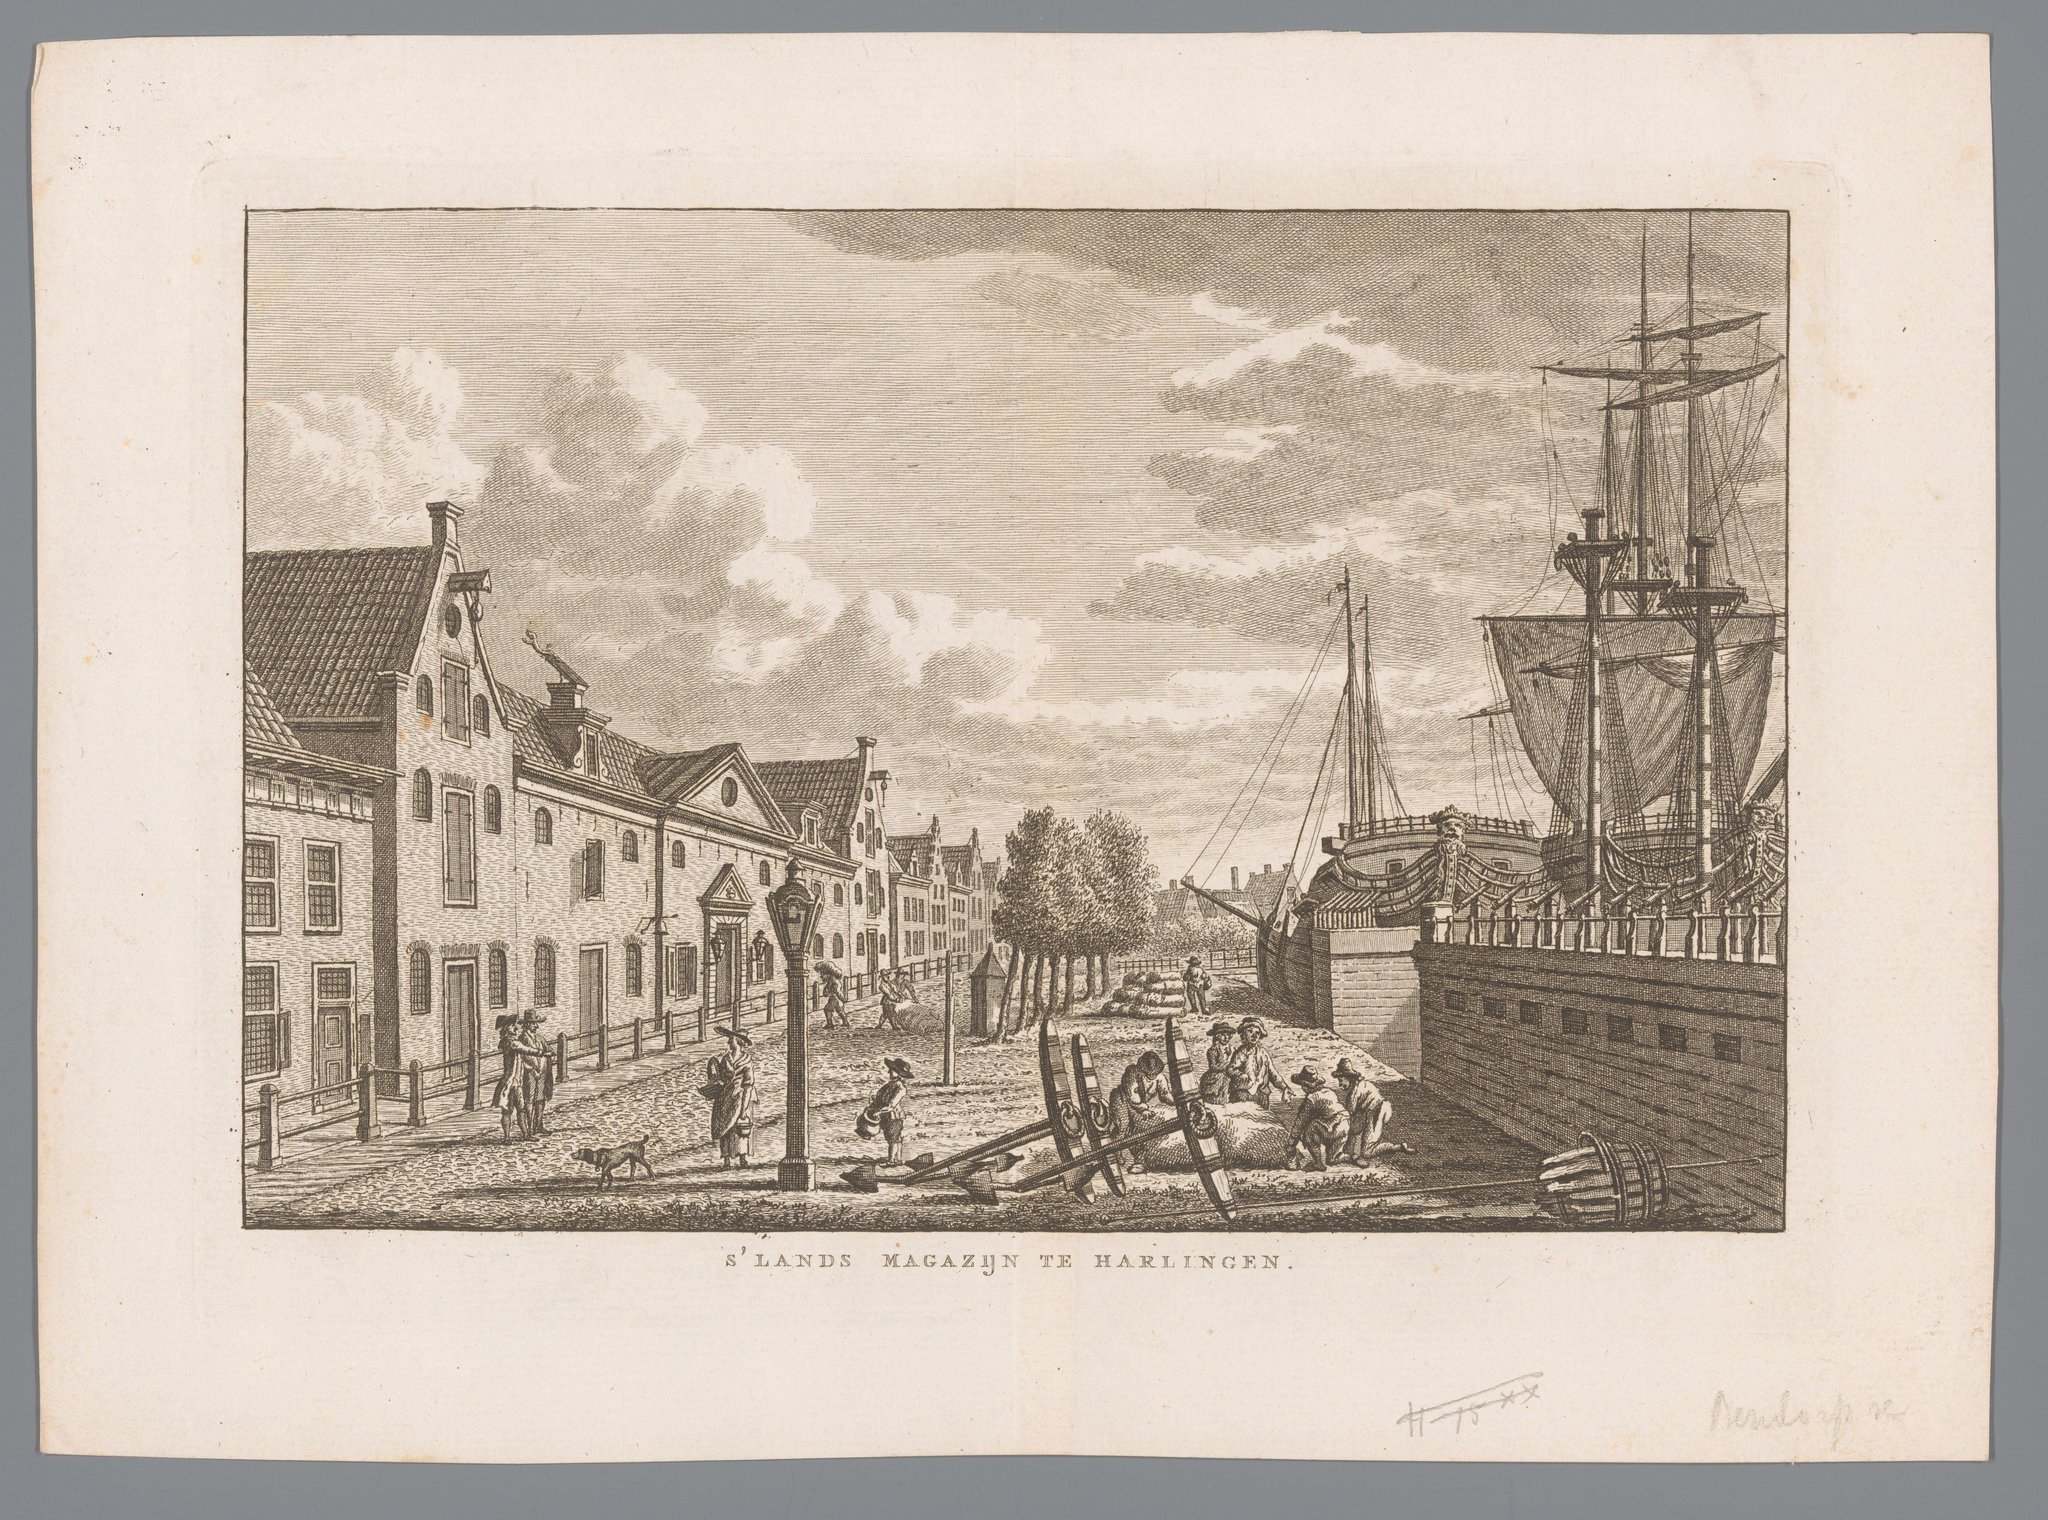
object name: print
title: s'Lands Magazijn te Harlingen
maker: carel frederik bendorp (i)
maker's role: print maker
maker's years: 1736-1814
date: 1786-1792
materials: paper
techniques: etching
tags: city-view, and landscape with man-made constructions, pier, quay, wharf, harlingen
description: Afgebeeld is niet de havenpoort van Franeker, zoals in de titel vermeld, maar die van Harlingen. Prent uit: Vaderlandsche gezichten, of afbeeldingen van den tegenwoordigen staat der Vereenigde Nederlanden (…). Amsterdam: Hendrik Gartman, Willem Vermandel en Jan Willem Smit, 1786-1792. Uitgegeven in afleveringen met ieder een eigen bifolium en inhoudsopgave. Alle prenten in deze publicatie zijn gegraveerd door Carel Frederik Bendorp (I) en, in de meeste gevallen, gebaseerd op tekeningen van Jan Bulthuis.